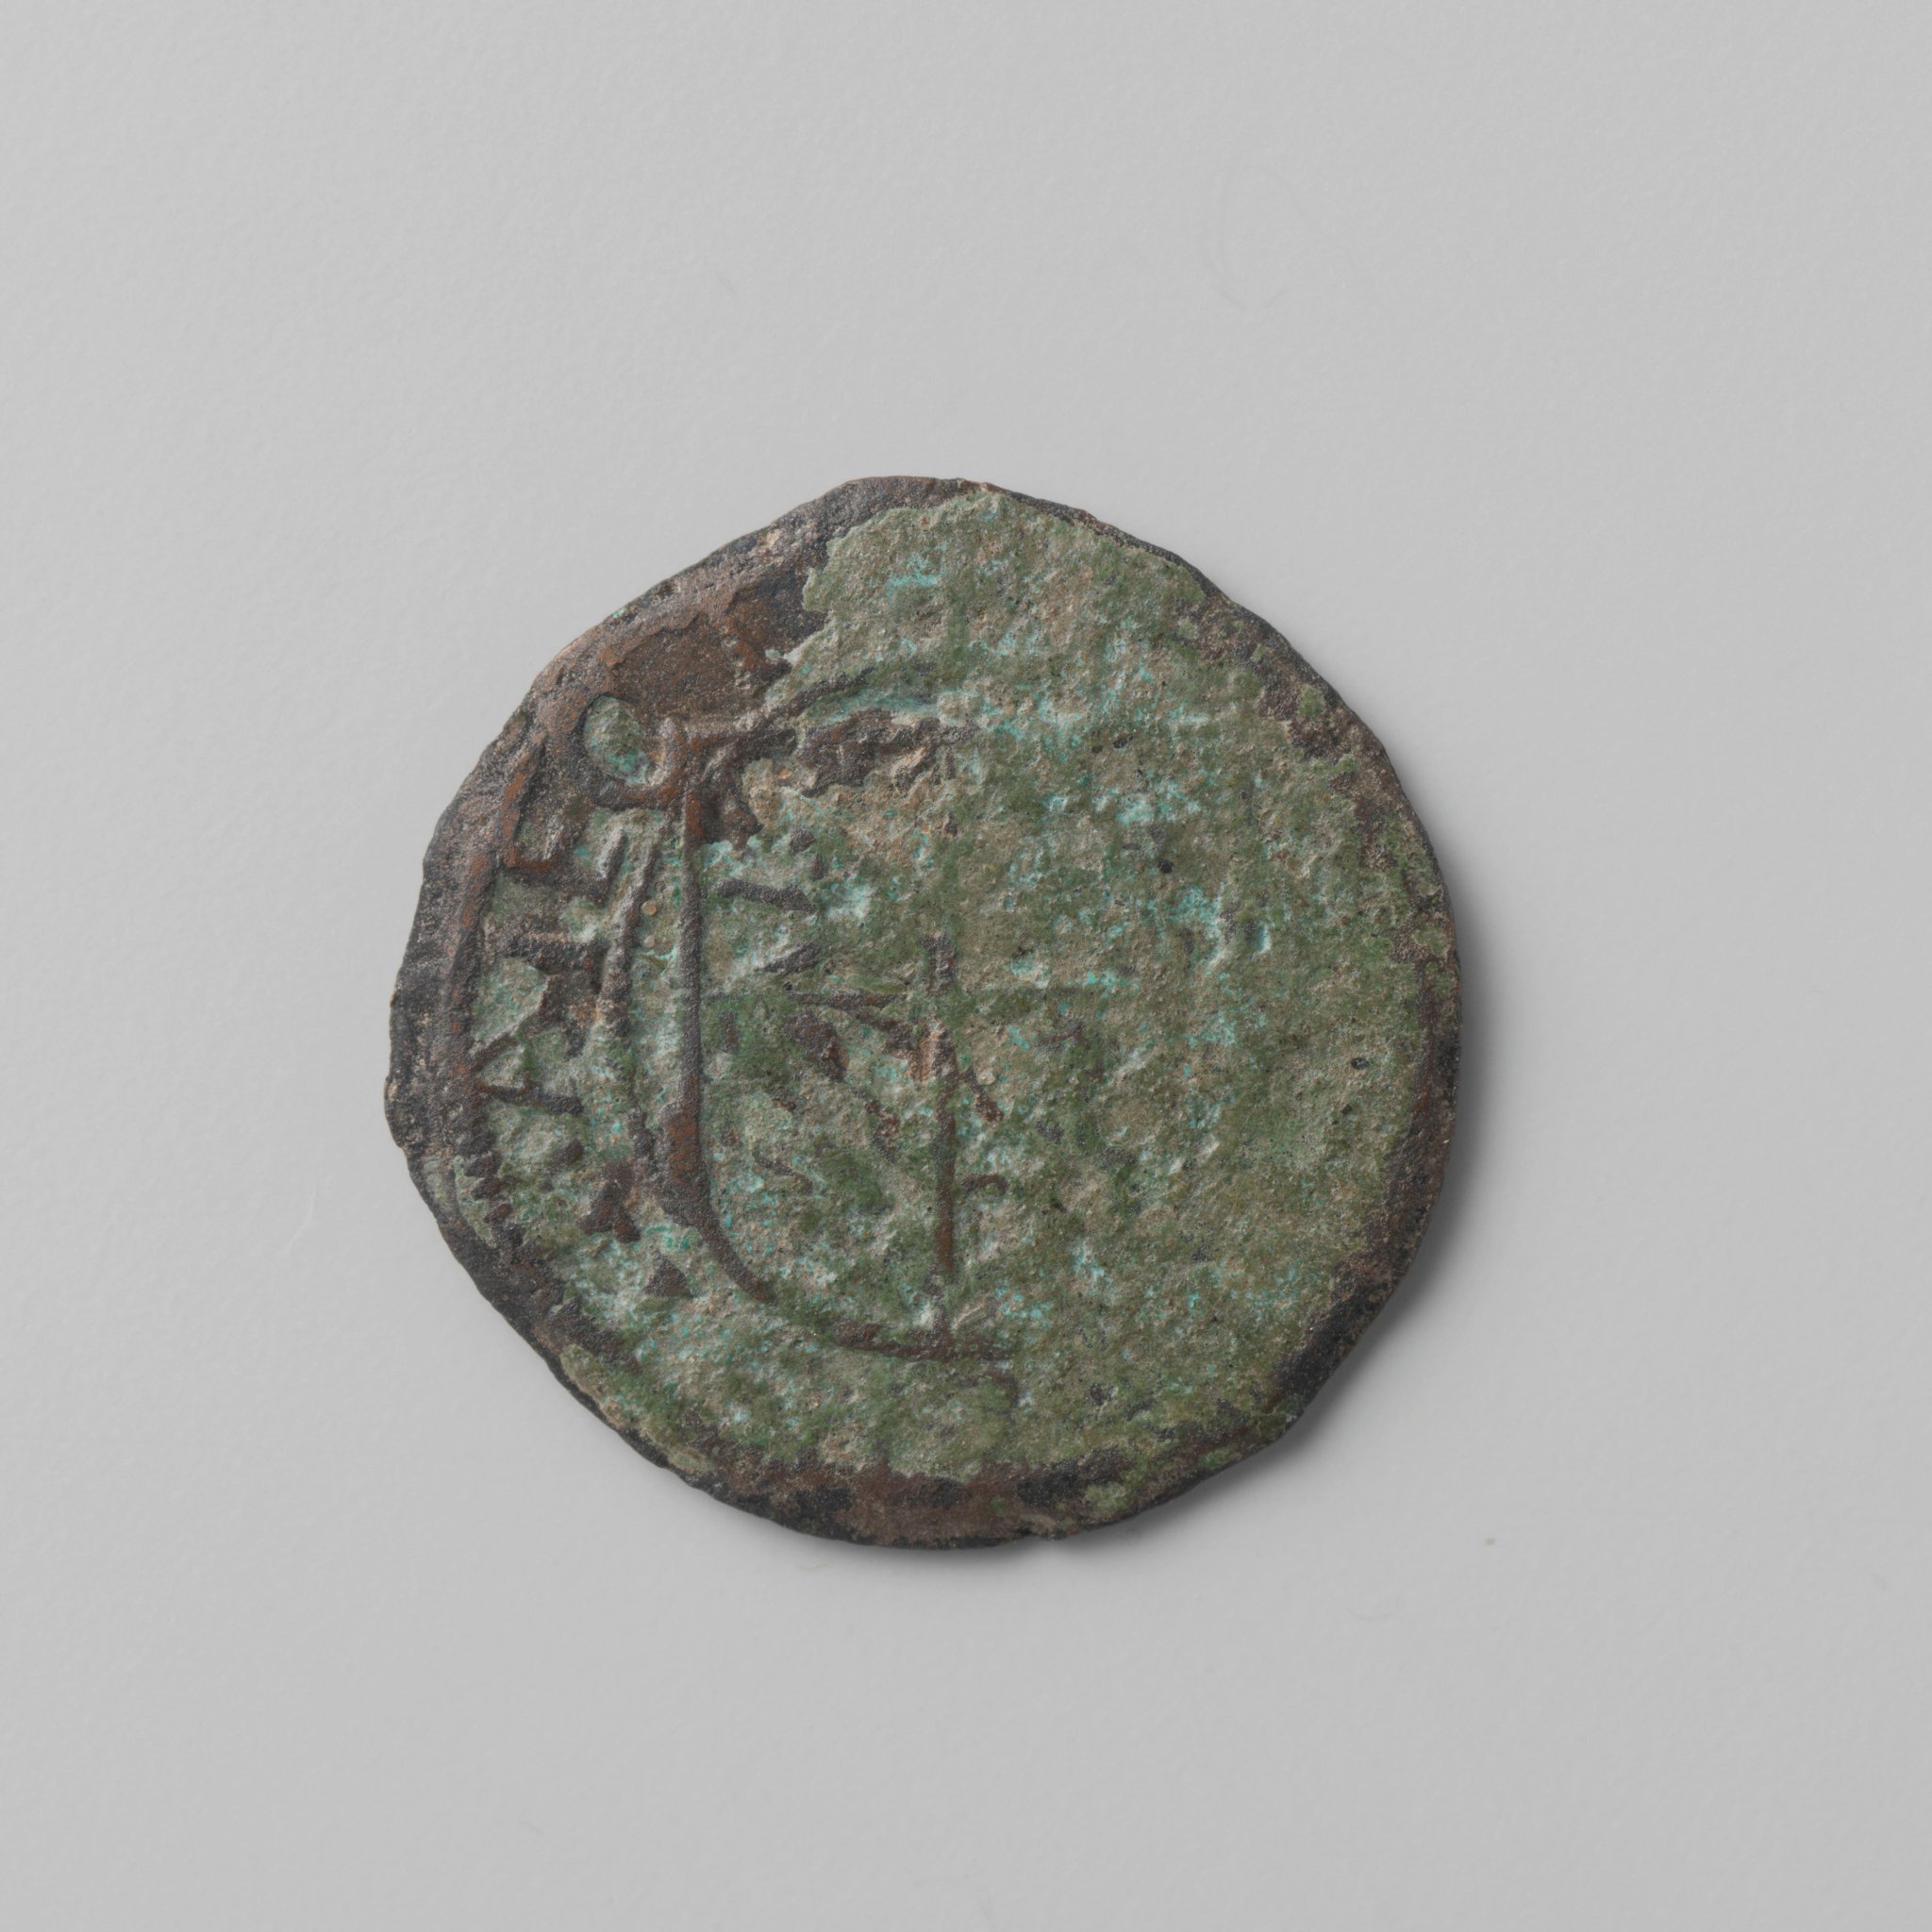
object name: coin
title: Utrechtse duit van Hendrik van Beieren, 1527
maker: hendrik van beieren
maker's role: bisschop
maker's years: 1487-1552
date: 1527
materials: copper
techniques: striking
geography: wijk bij duurstede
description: Koper-zilveren munt. Voorzijde: wapenschild. Keerzijde: lang gevoet kruis met in het hart halve maan en in de hoeken leeuwtjes.